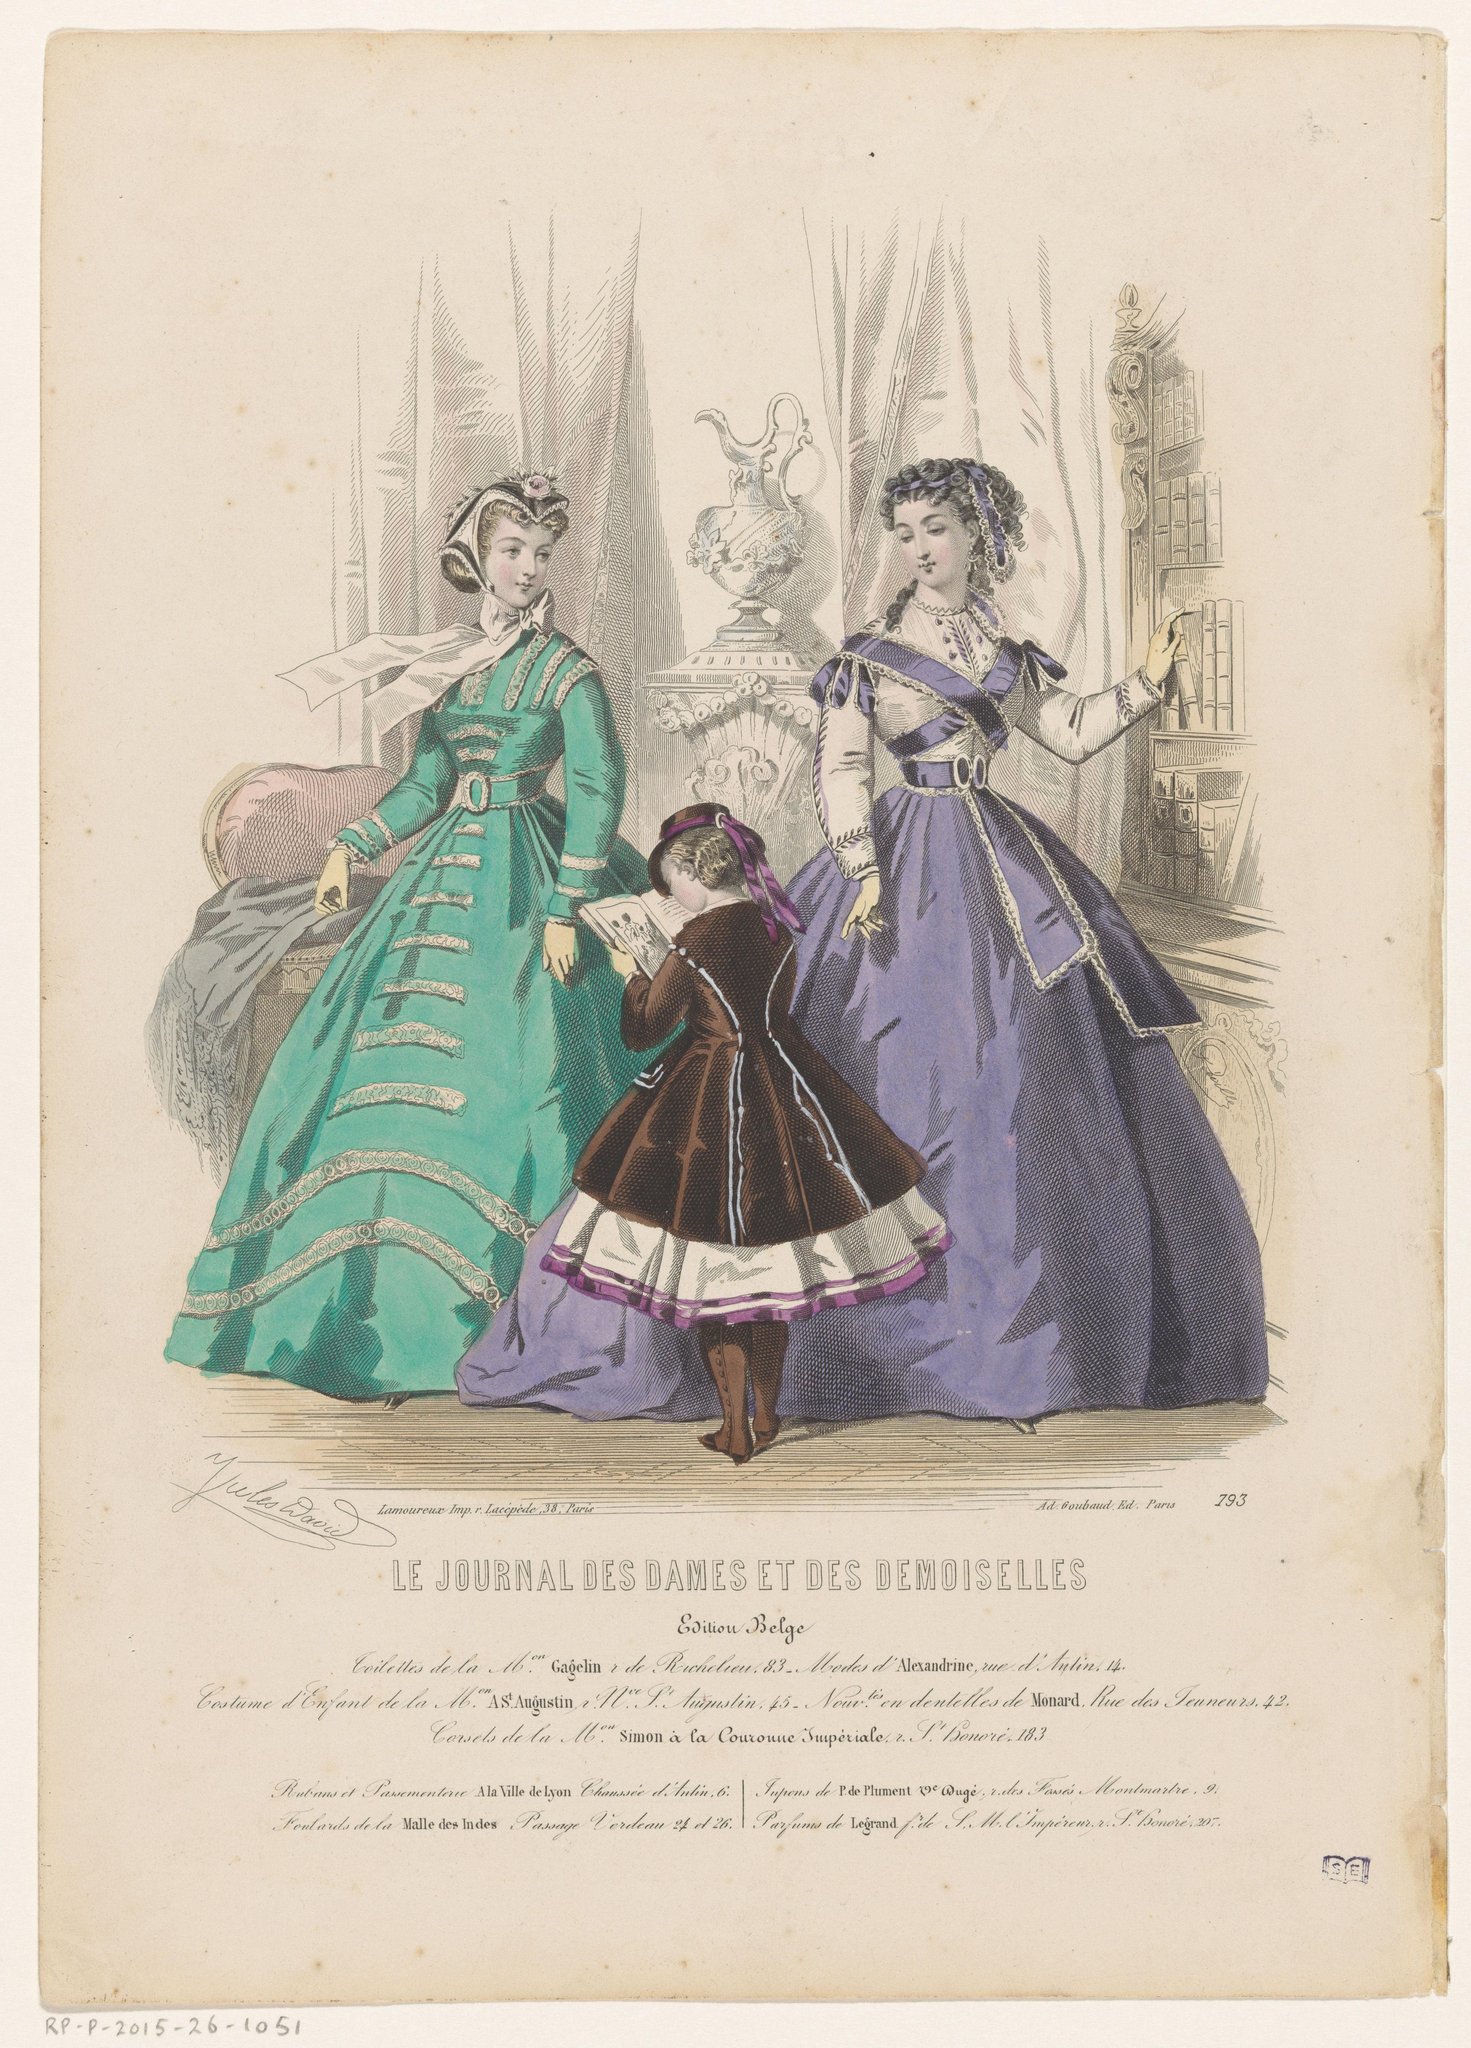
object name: fashion print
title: Lezend meisje en twee vrouwen in een bibliotheek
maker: jules david (1808-1892)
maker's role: draughtsman, painter, print maker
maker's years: 1808-1892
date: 1841-1892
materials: paper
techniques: engraving, hand coloring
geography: paris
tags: fashion plates, study; 'studiolo'; library, newspaper, news-sheet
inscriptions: collector's mark: Lugt 2228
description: Op de voorgrond een lezend meisje op haar rug gezien. Een van de vrouwen pakt een boek uit de boekenkast. In de achtergrond een vaas op een sokkel. Rechtsonder genummerd: 793.